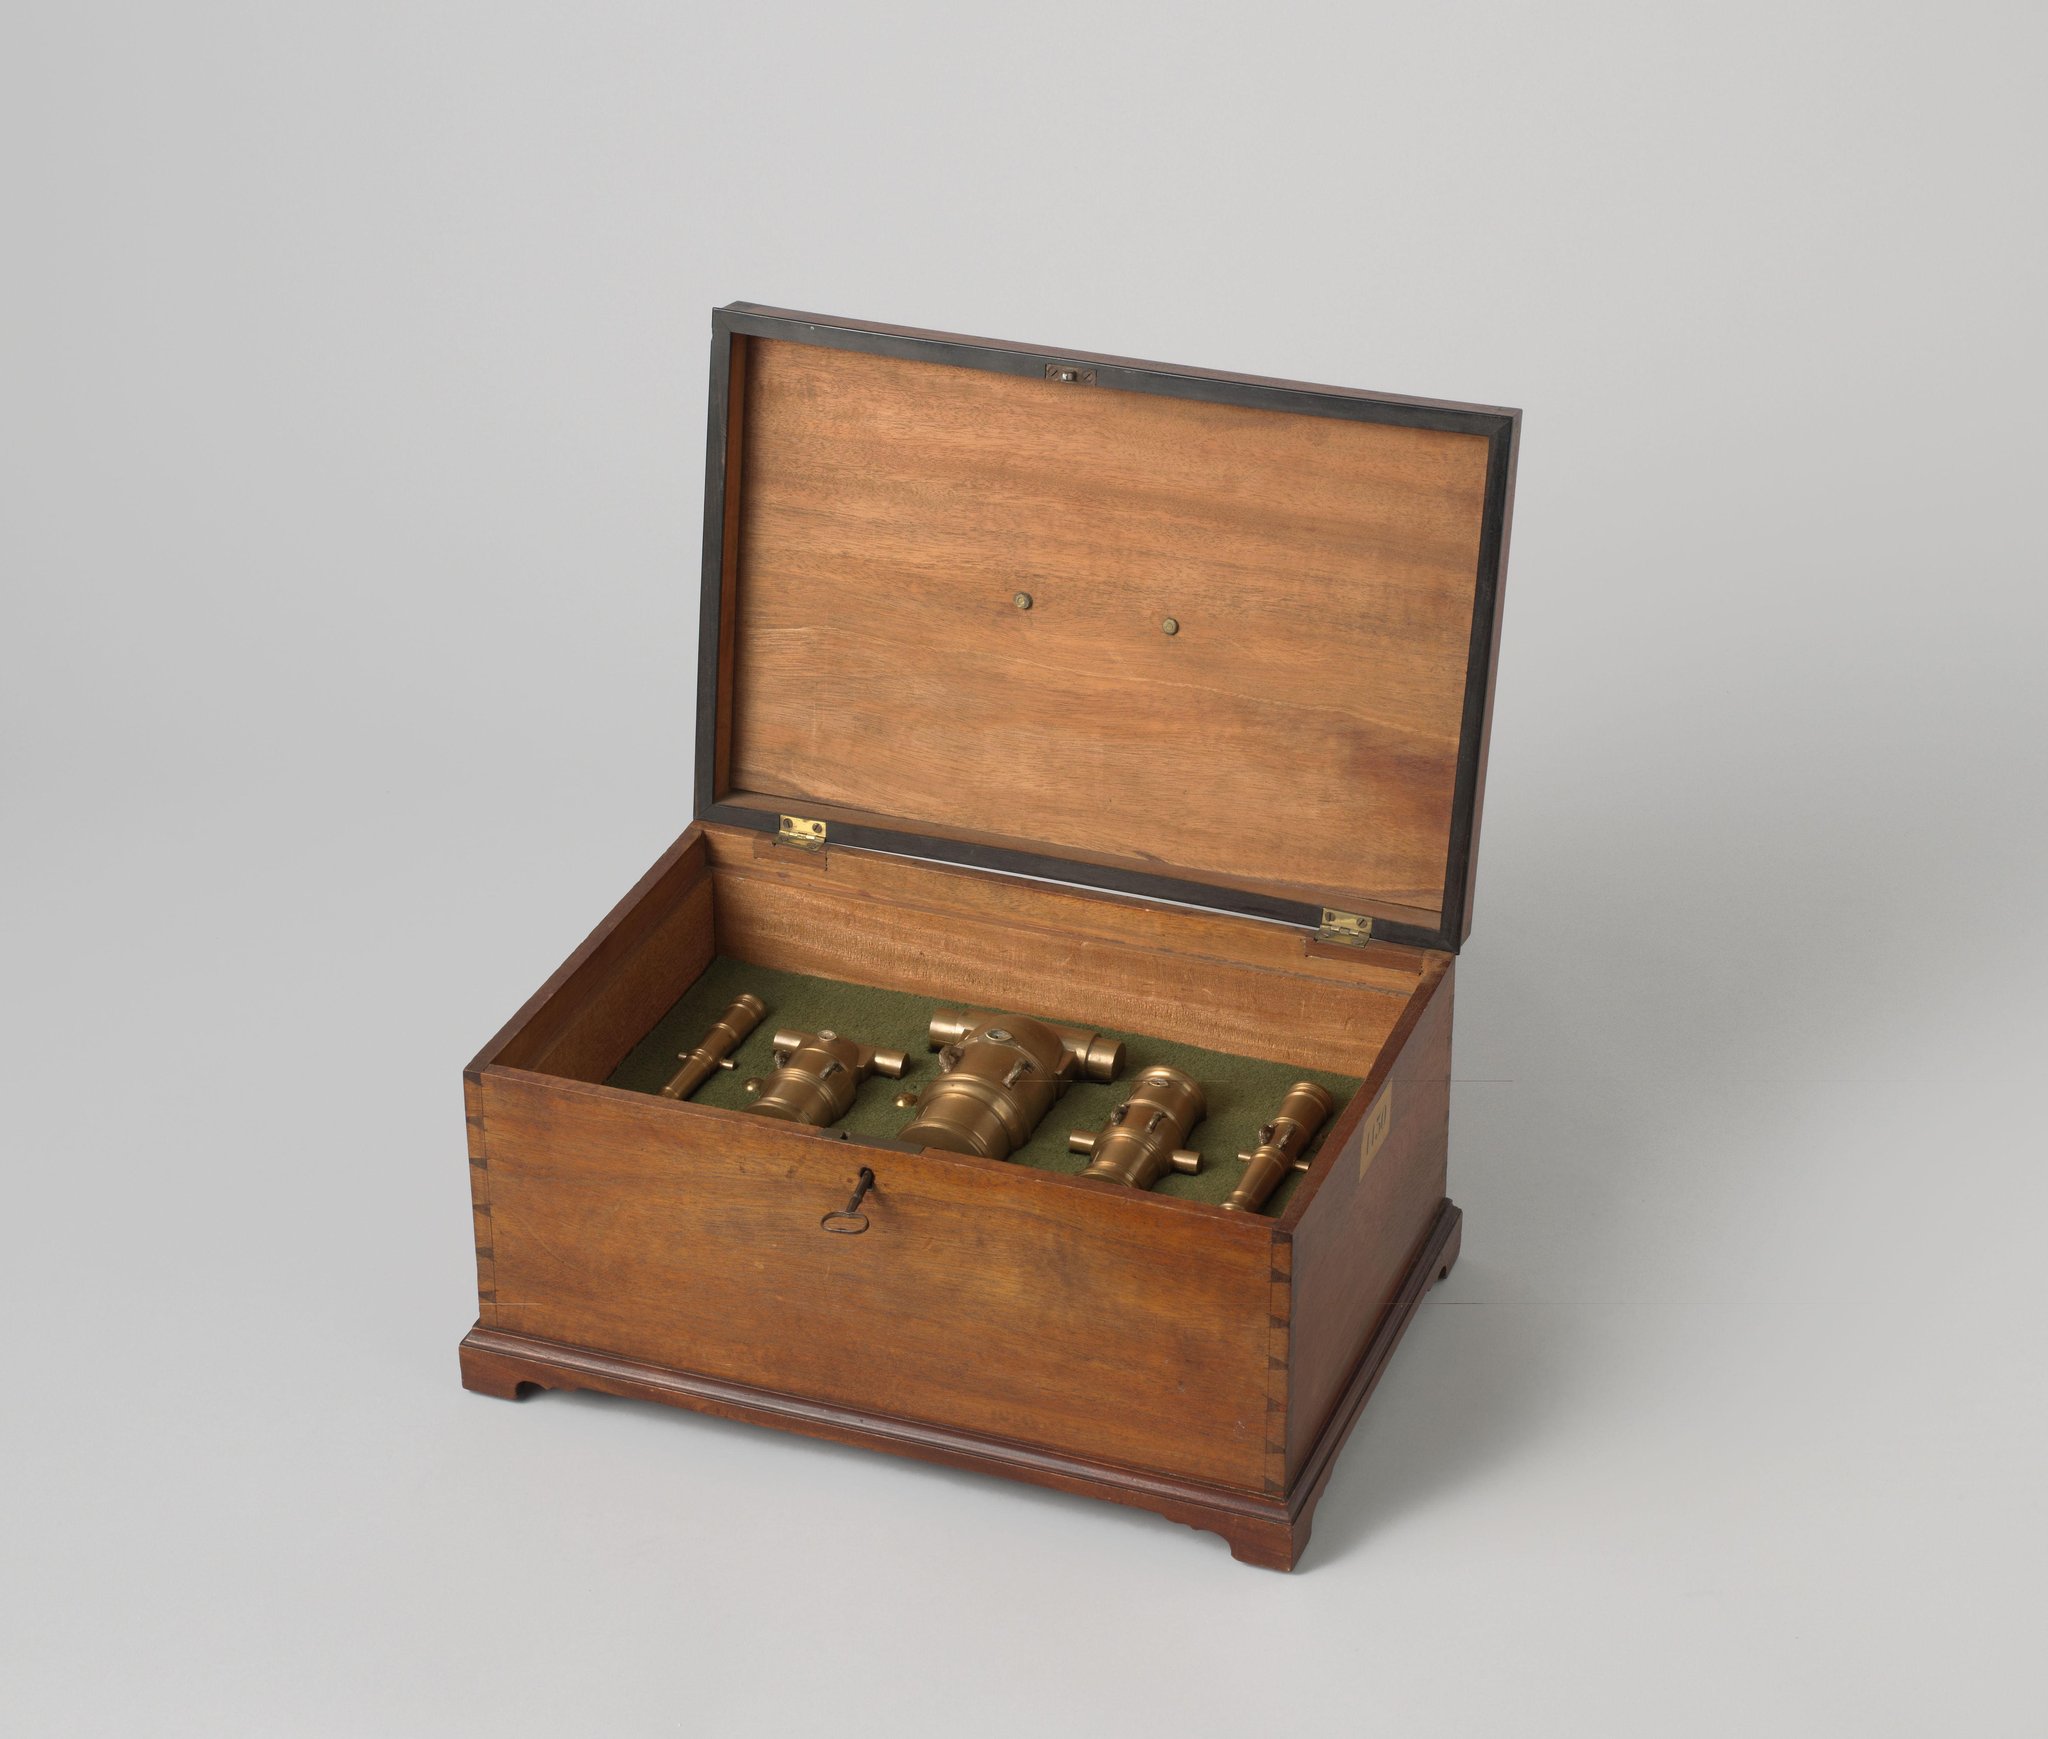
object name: presentation model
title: Box Containing Six Models of Guns and Four Documents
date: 1778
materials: brass, bronze, textile, iron, paper, wood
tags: enkhuizen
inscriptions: date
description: Houten kist met zes fraai uitgevoerde bronzen geschutmodellen. De geschutmodellen, twee mortieren, een houwitser en drie kanonnen, zijn allemaal in de lengte doorgesneden om de ziel te kunnen laten zien. Alle lopen behalve het kleinste kanon zijn voorzien van dolfijnen, het zundgat van de twee mortieren en de houwitser heeft de vorm van een schelp. Alle lopen zijn van tappen voorzien, bij de mortieren onderaan. Hierbij behoren vier documenten die in de valse bodem van de kist gevonden zijn. Schaal 1:12 (afgeleid).